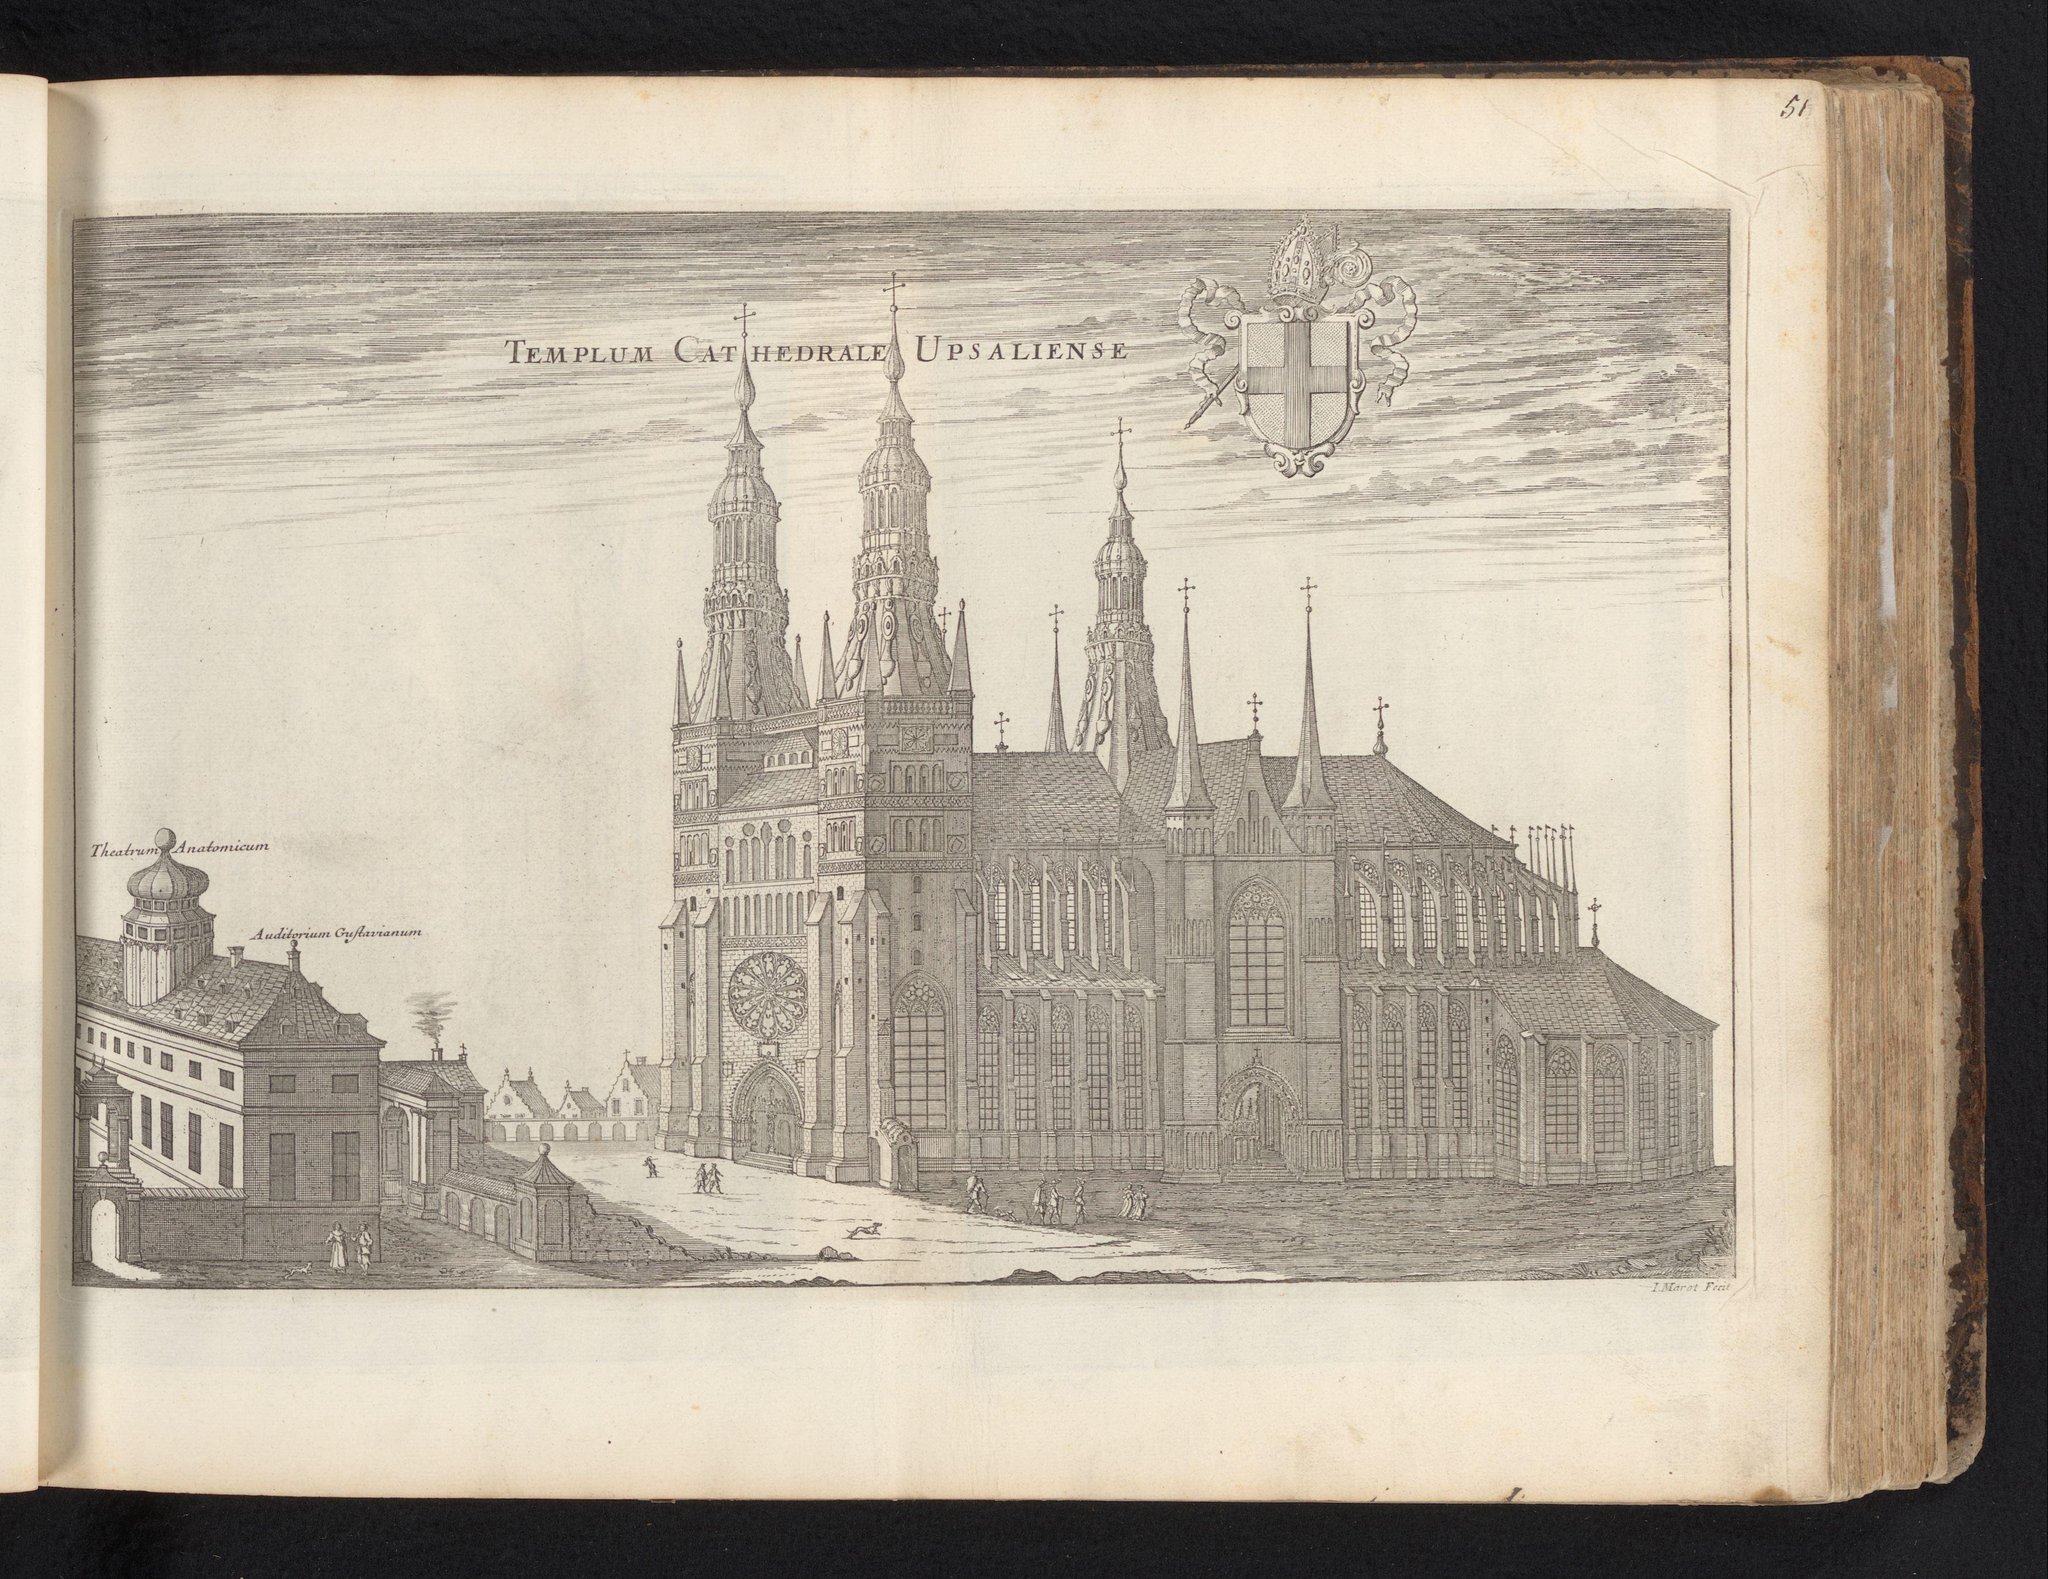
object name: album leaf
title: Suecia Antiqua et Hodierna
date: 1670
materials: paper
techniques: etching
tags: church (exterior)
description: Gezicht op de kathedraal van Uppsala met links het anatomisch theater en het Gustavianum aldaar. De prent maakt deel uit van een album.